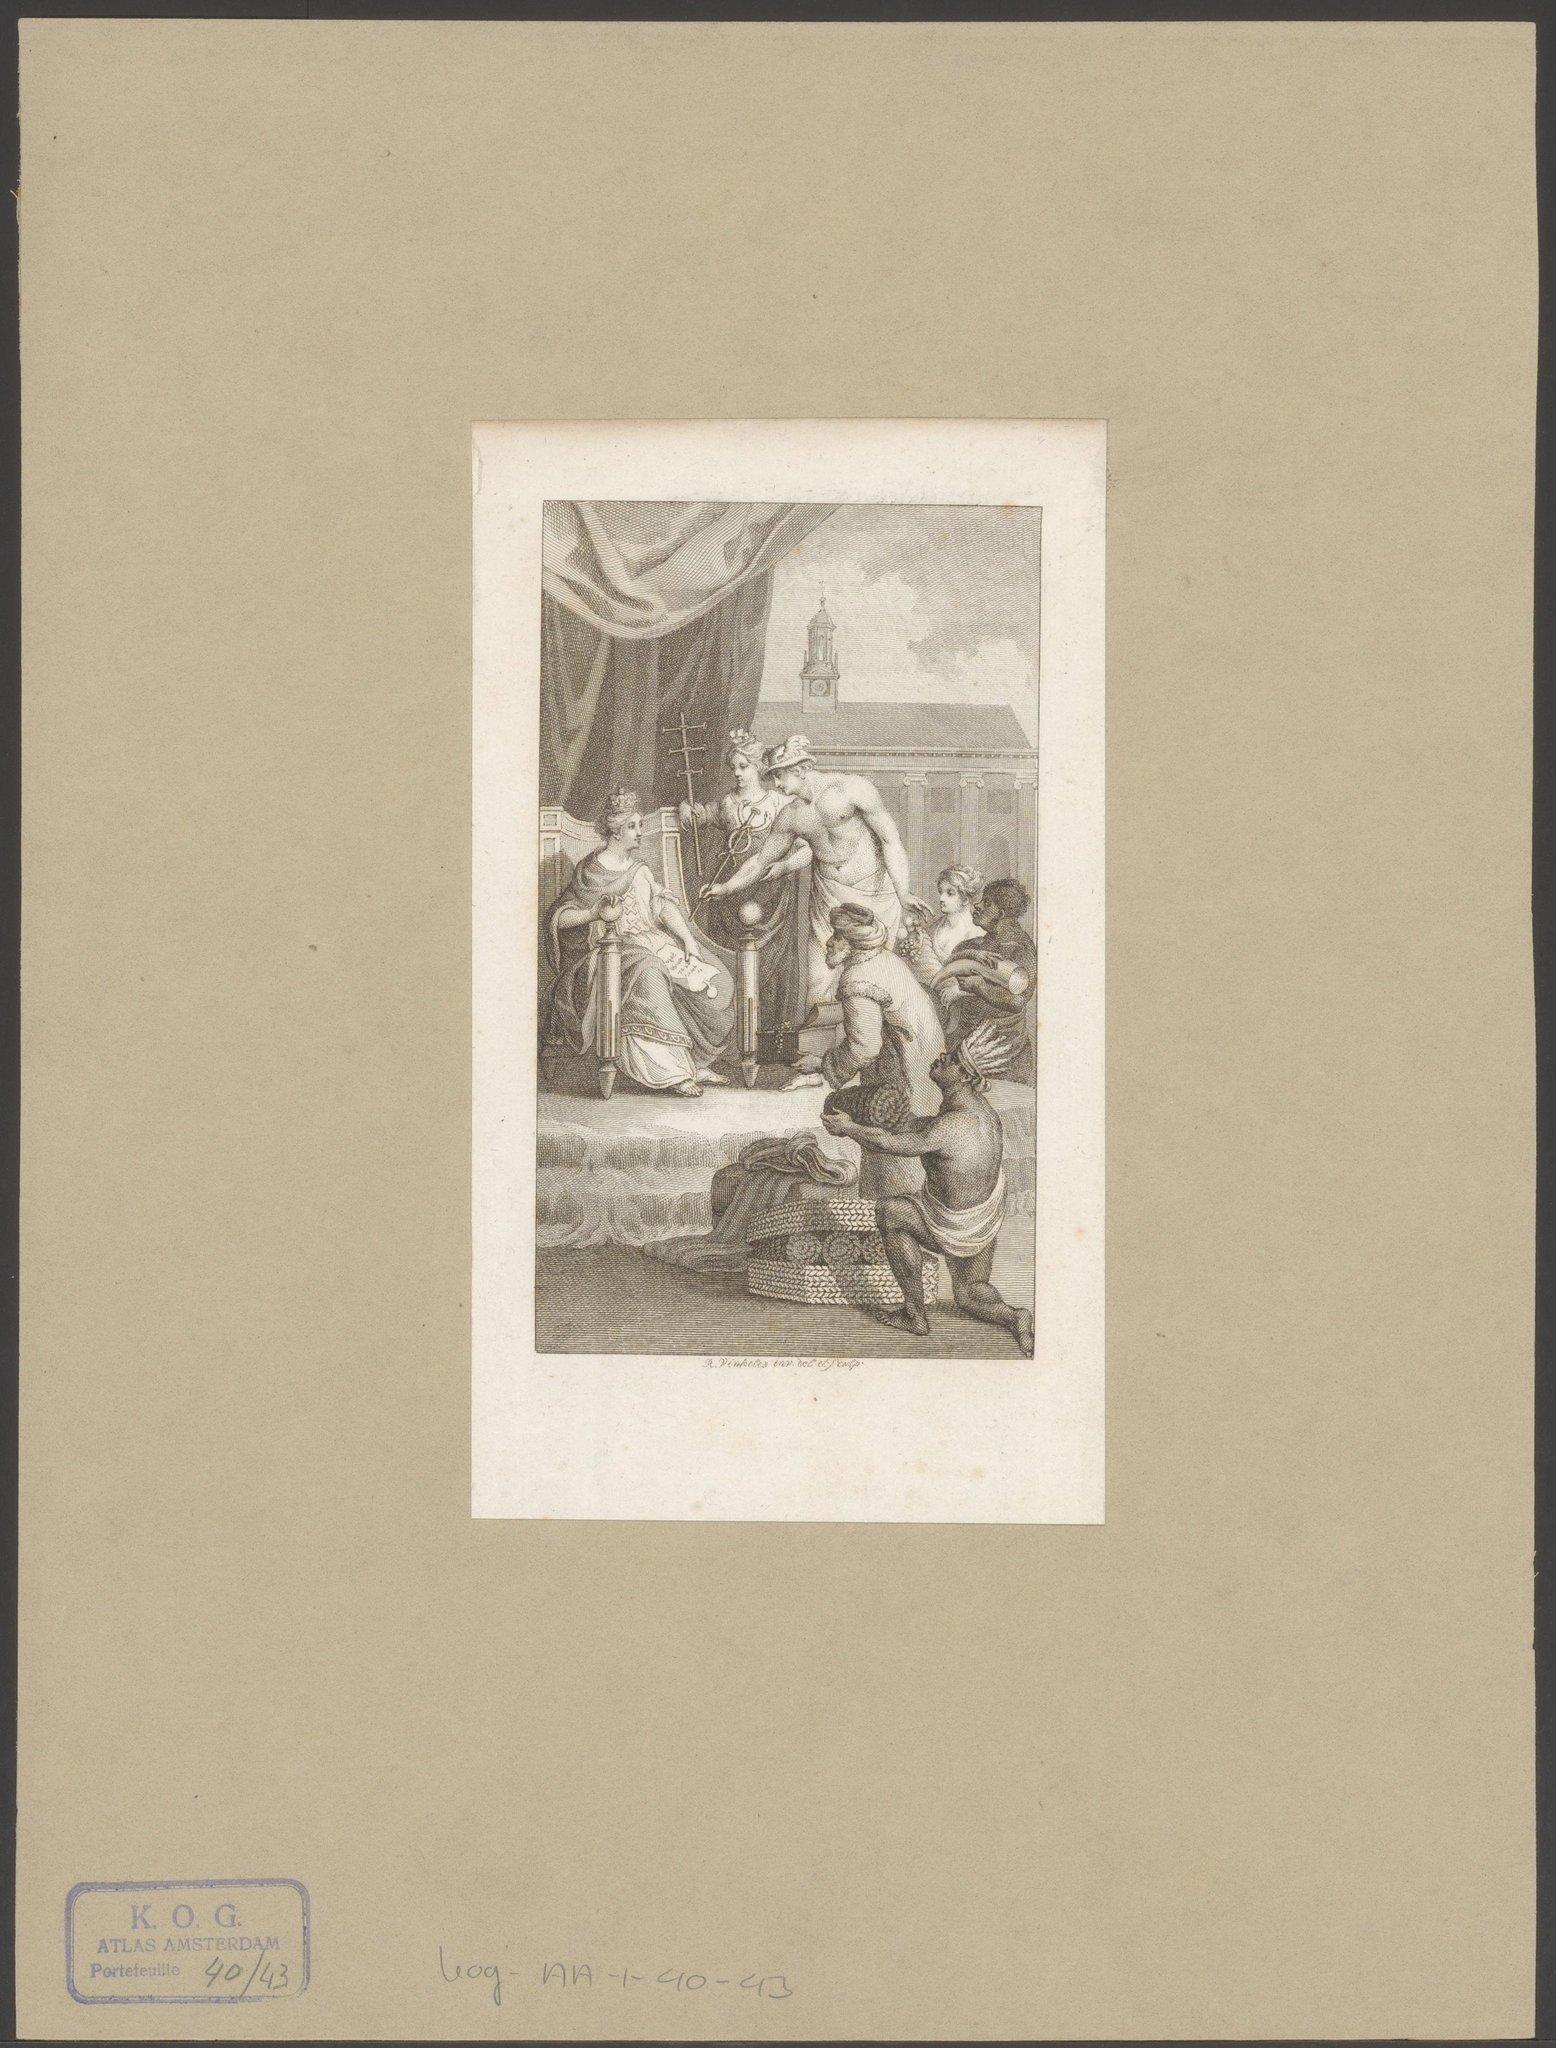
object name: print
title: Allegorie op de Amsterdamse beurs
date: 1813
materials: paper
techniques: etching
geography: amsterdam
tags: (story of) mercury (hermes), personification of a city, town-patron(ess), stock exchange, stock-market, continents represented allegorically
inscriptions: collector's mark: Lugt 1641b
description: Allegorische voorstellingen van de werelddelen, handel en scheepsvaart brengen hulde aan de Amsterdamse stedenmaagd. Onderwerpsrubriek binnen de Atlas Amsterdam: Handel en Zeevaart: Beurs op het Rokin.